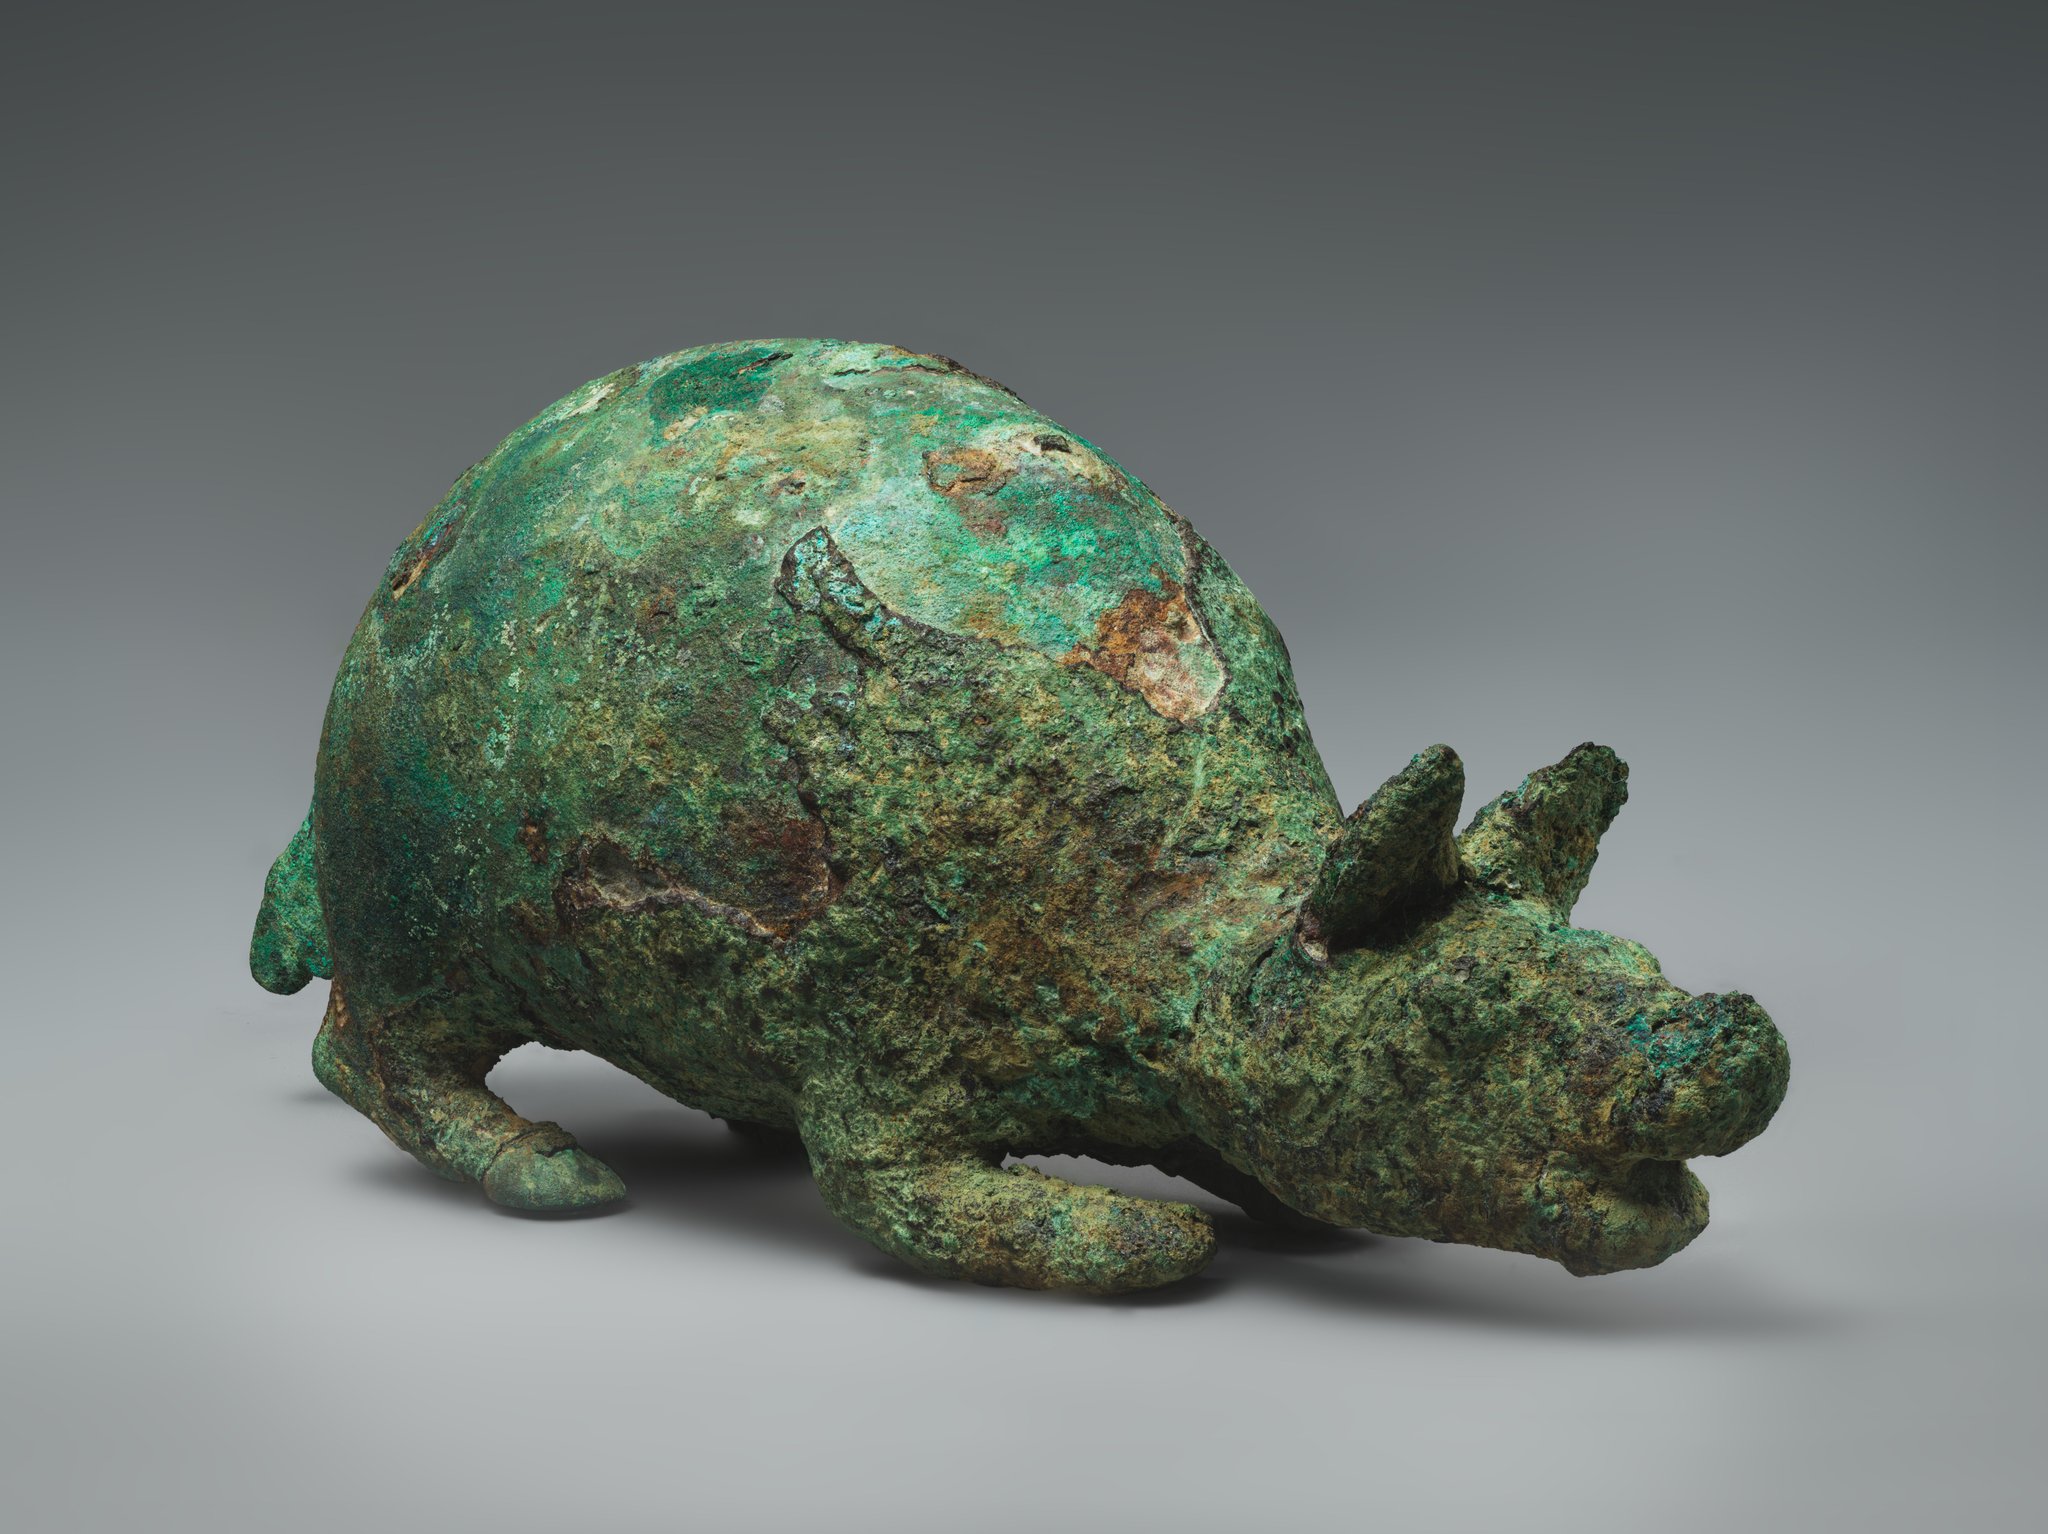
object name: sculpture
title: Quadruped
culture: sasanian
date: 201-700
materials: bronze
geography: iran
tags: animals